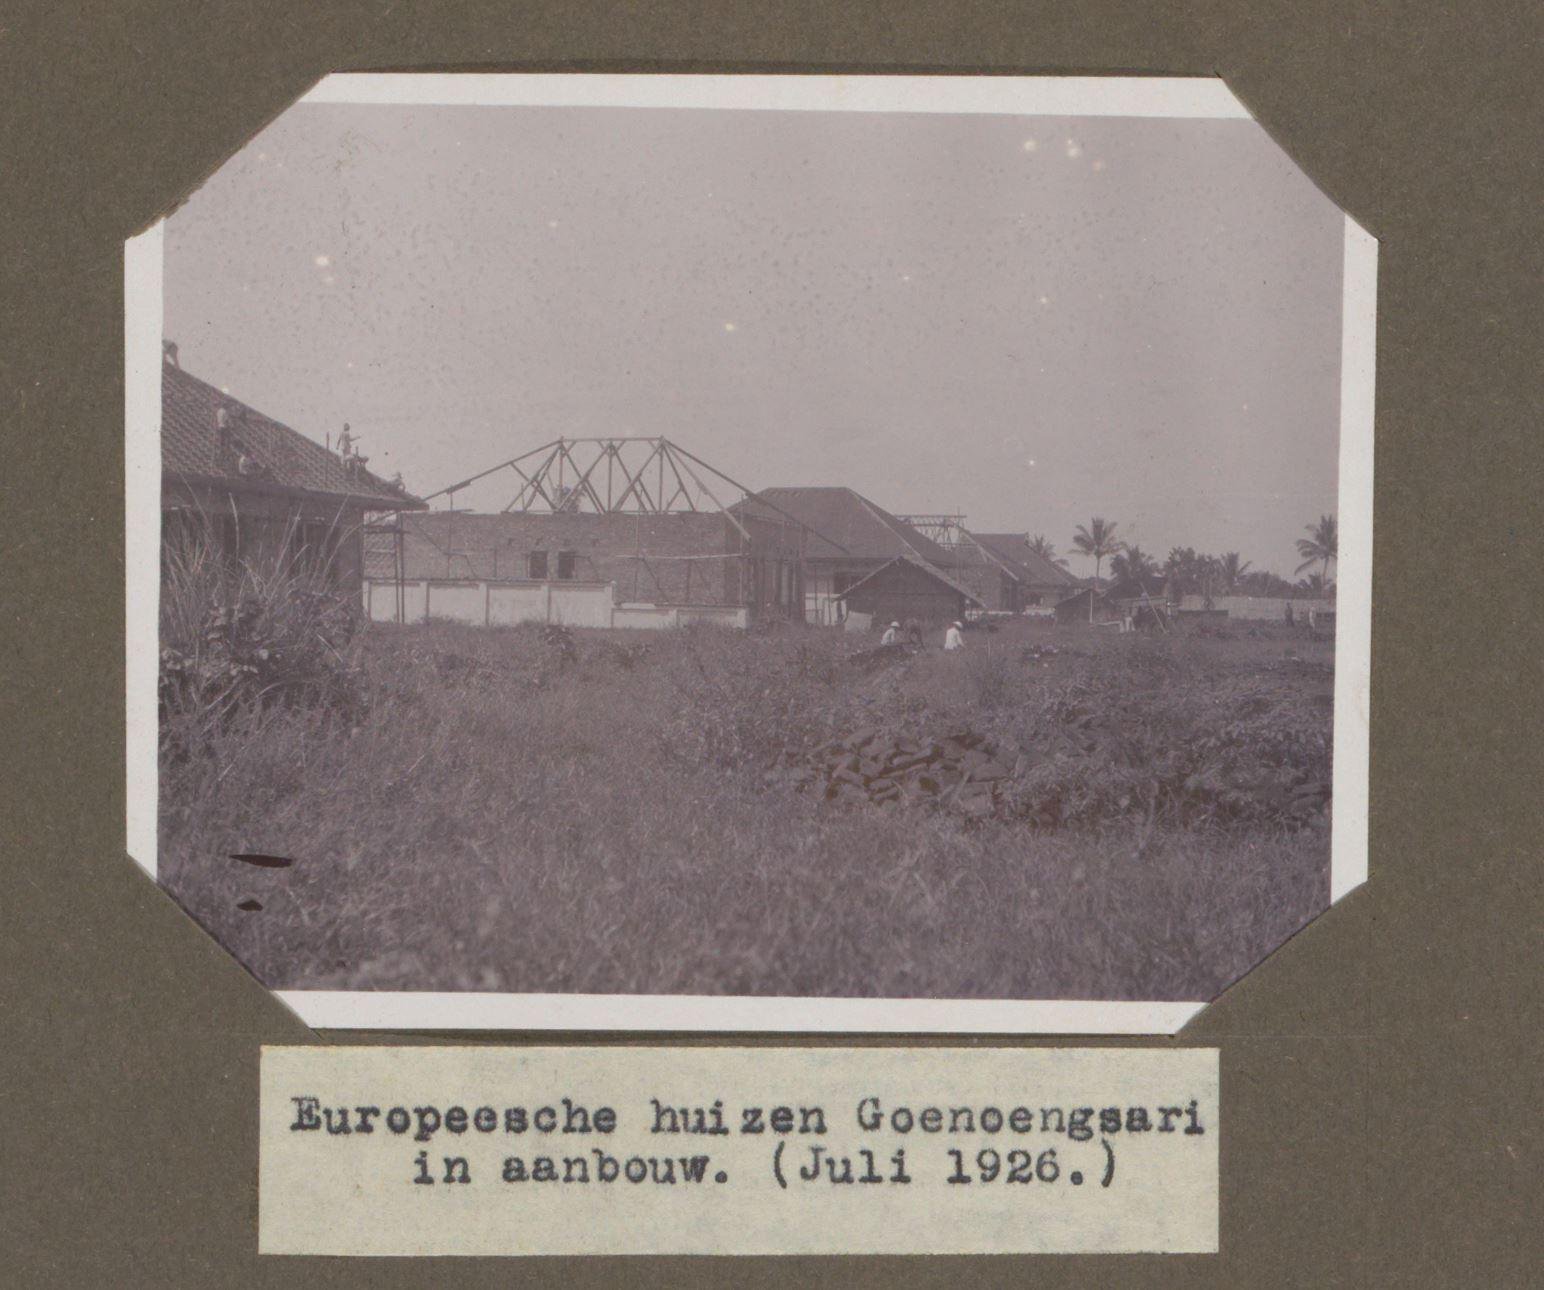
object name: photograph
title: Europeesche huizen Goenoengsari in aanbouw. (Juli 1926.)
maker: Anonymous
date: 1907-1926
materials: photographic support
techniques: gelatin silver print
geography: east java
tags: colonial system, trade-company, making the overground structures (~ building activities), (non-fruit) products of plants or trees: sugarcane, representation of real building (either existing or having existed)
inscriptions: inscription: ‘Europeesche huizen Goenoengsari in aanbouw. (Juli 1926.)’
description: Bouw van de huizen voor het Europese personeel van de fabriek, juli 1926. Onderdeel van het fotoalbum met foto's van de opbouw van de suikerfabriek te Goenoengsari op Oost-Java door de Handels Vereniging Amsterdam 1926-1927.